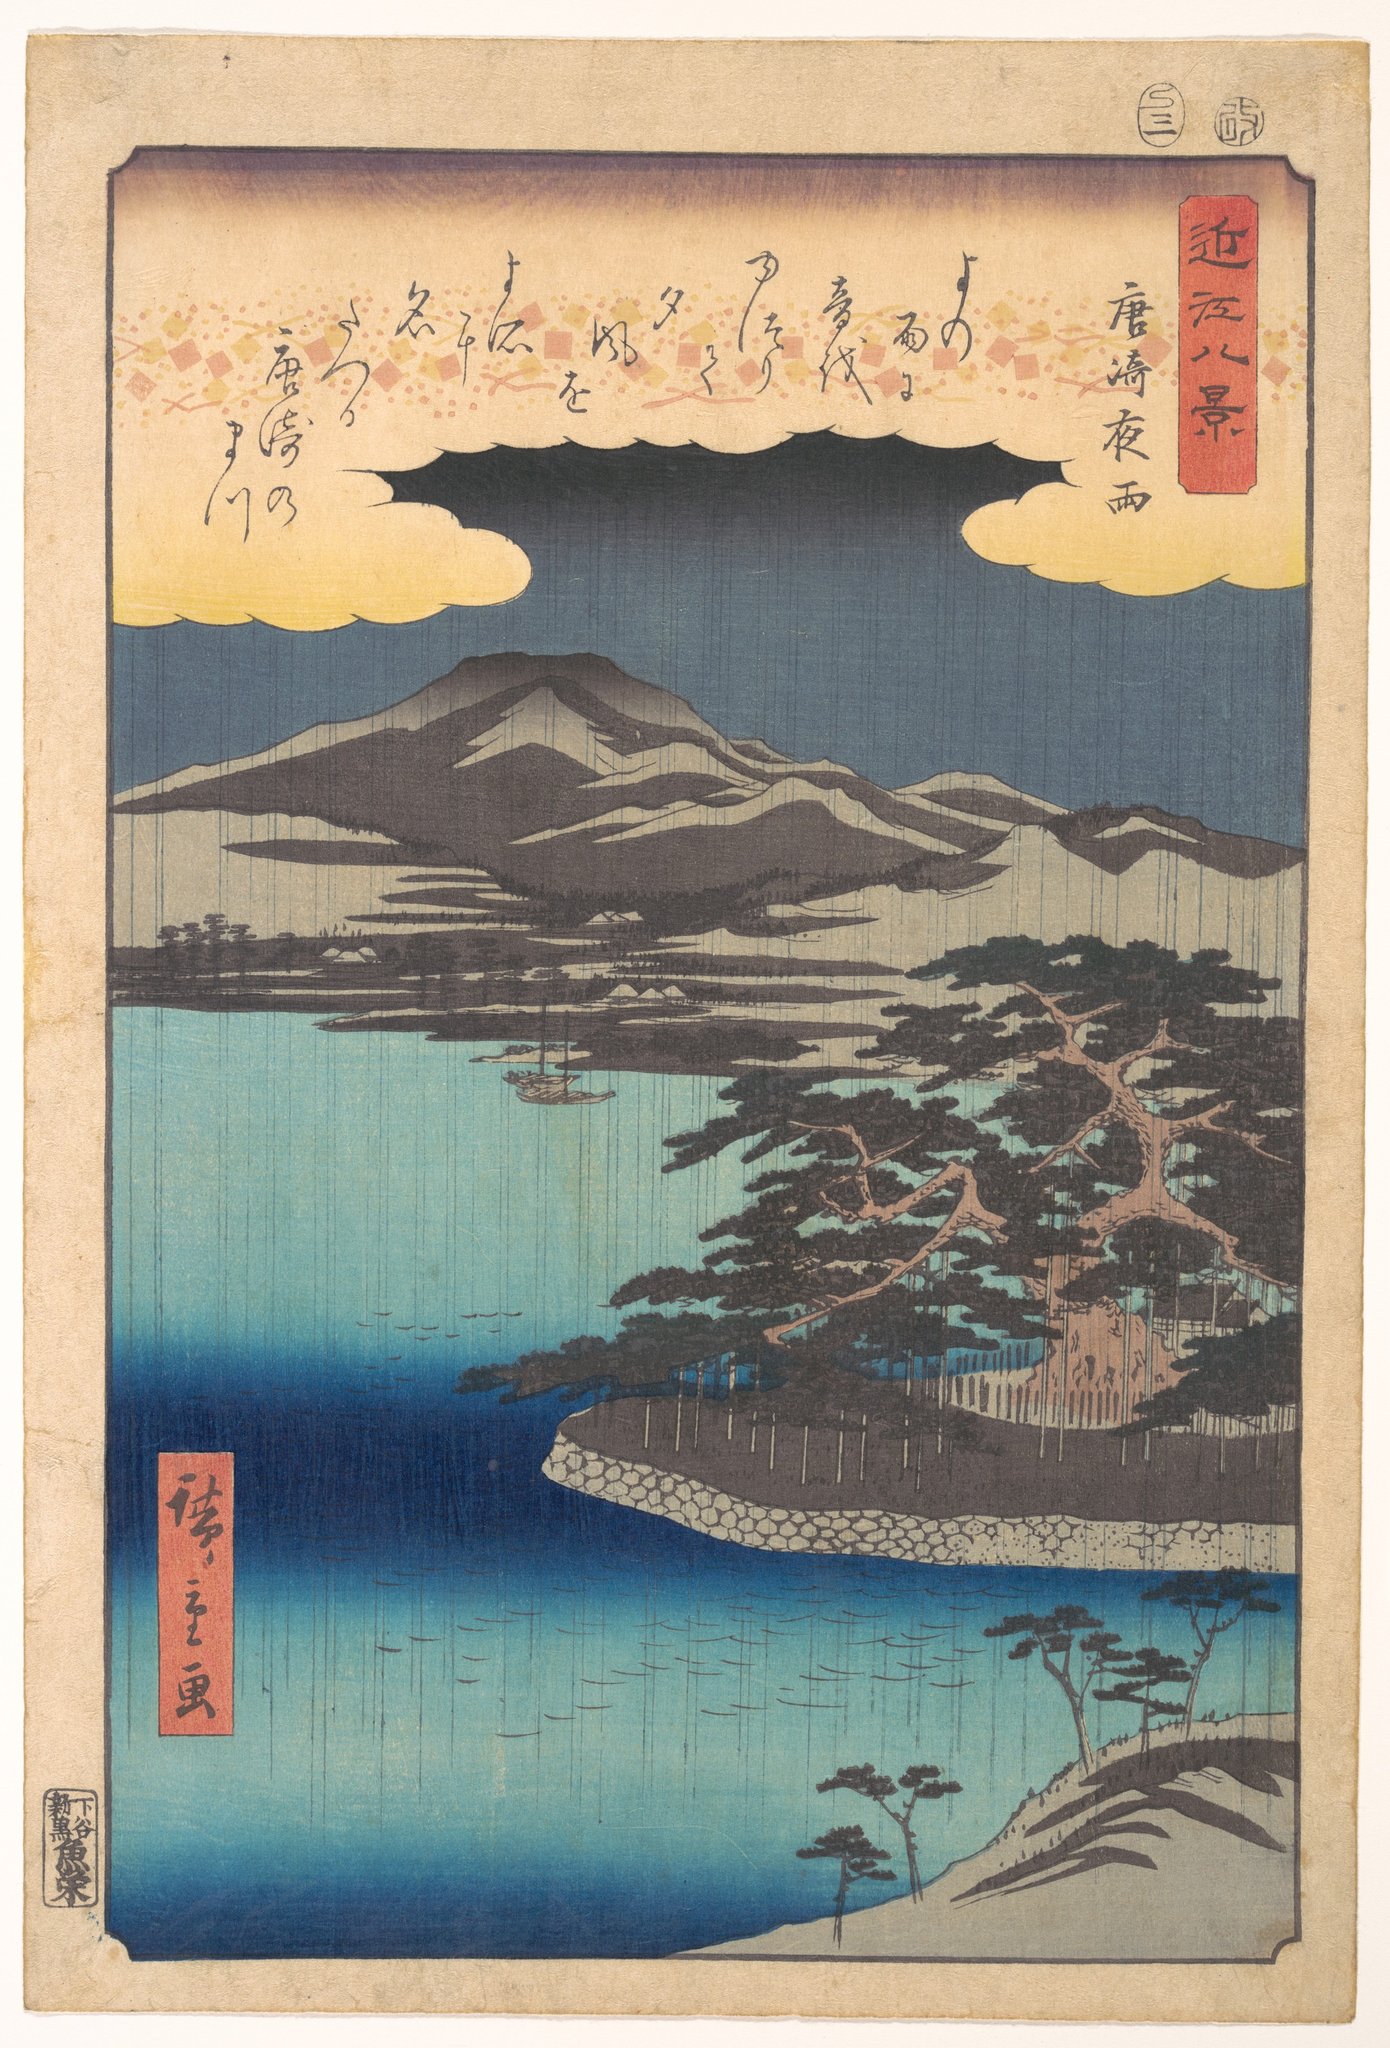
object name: print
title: Pine Tree at Karasaki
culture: japanese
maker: utagawa hiroshige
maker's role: artist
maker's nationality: japanese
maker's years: 1797-1858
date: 1857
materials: ink, paper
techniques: woodblock print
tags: mountains,landscapes,rain